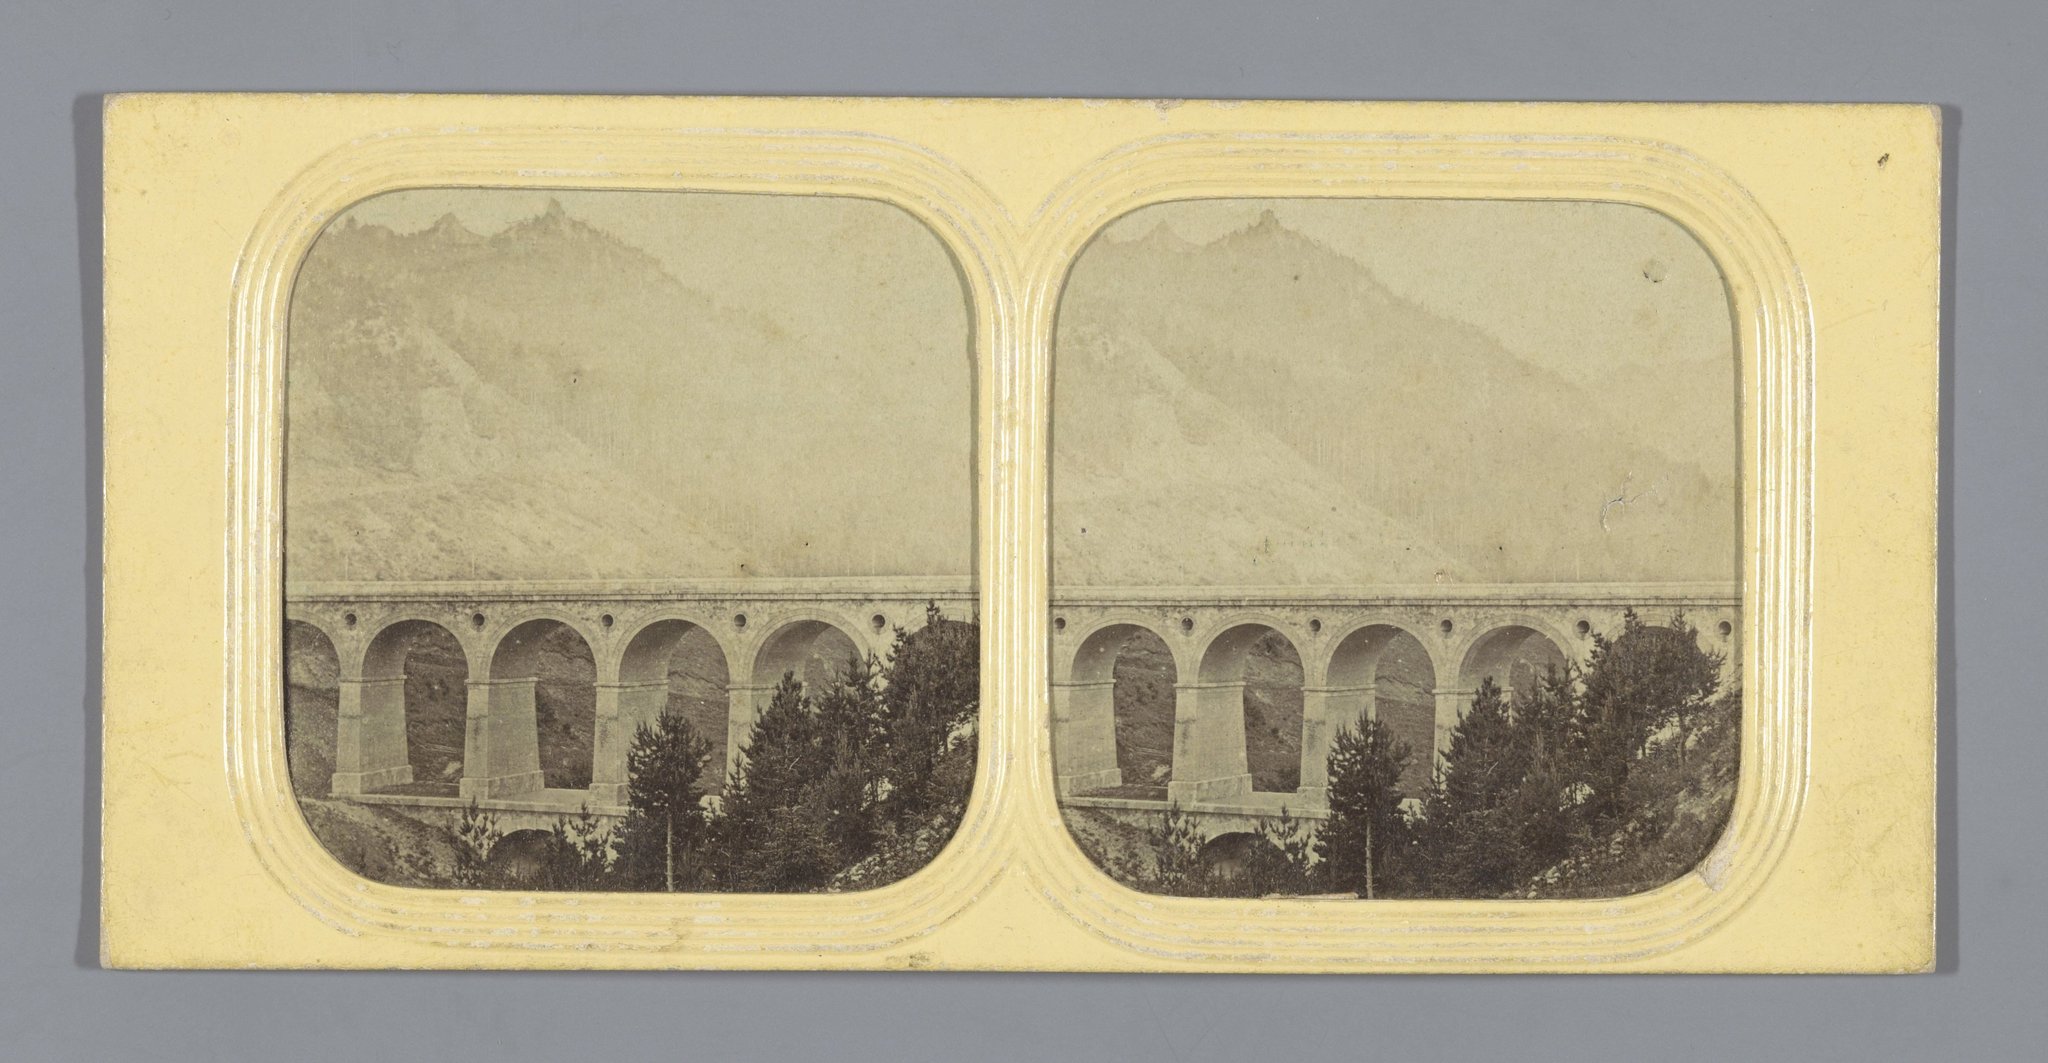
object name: tissue stereograph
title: Aquaduct in Duitsland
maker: Anonymous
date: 1855-1875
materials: cardboard, paper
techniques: albumen print, hand coloring, perforating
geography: germany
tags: landscape with bridge, viaduct or aqueduct, germany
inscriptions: number: ‘14.’